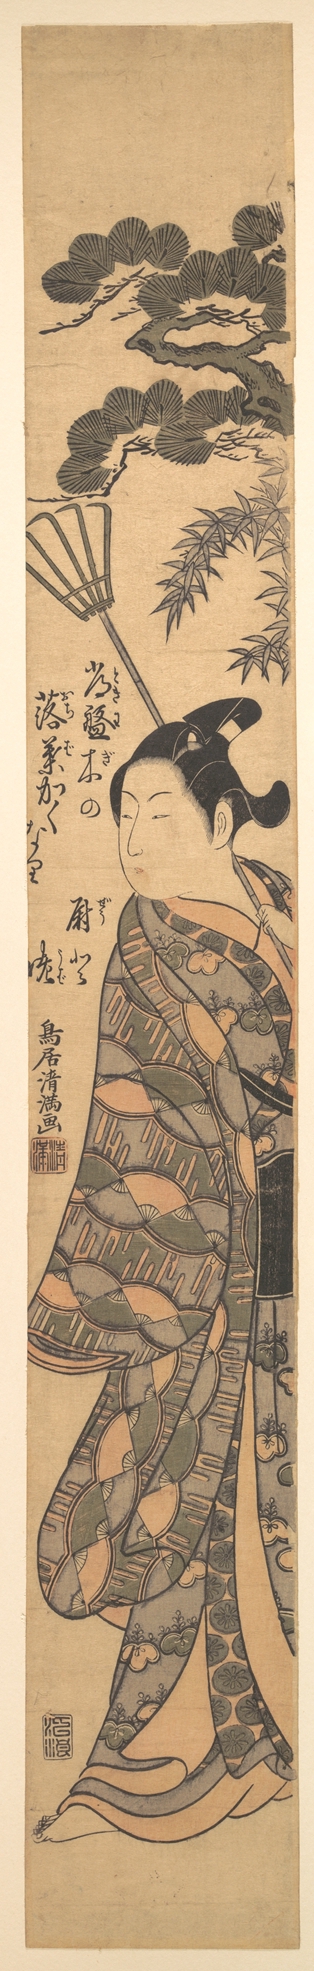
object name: print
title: A Tall Young Man Carrying a Bamboo Rake Over His Left Shoulder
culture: japanese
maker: torii kiyomitsu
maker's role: artist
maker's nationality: japanese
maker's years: 1735-1785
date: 1763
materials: ink, paper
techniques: woodblock print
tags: men